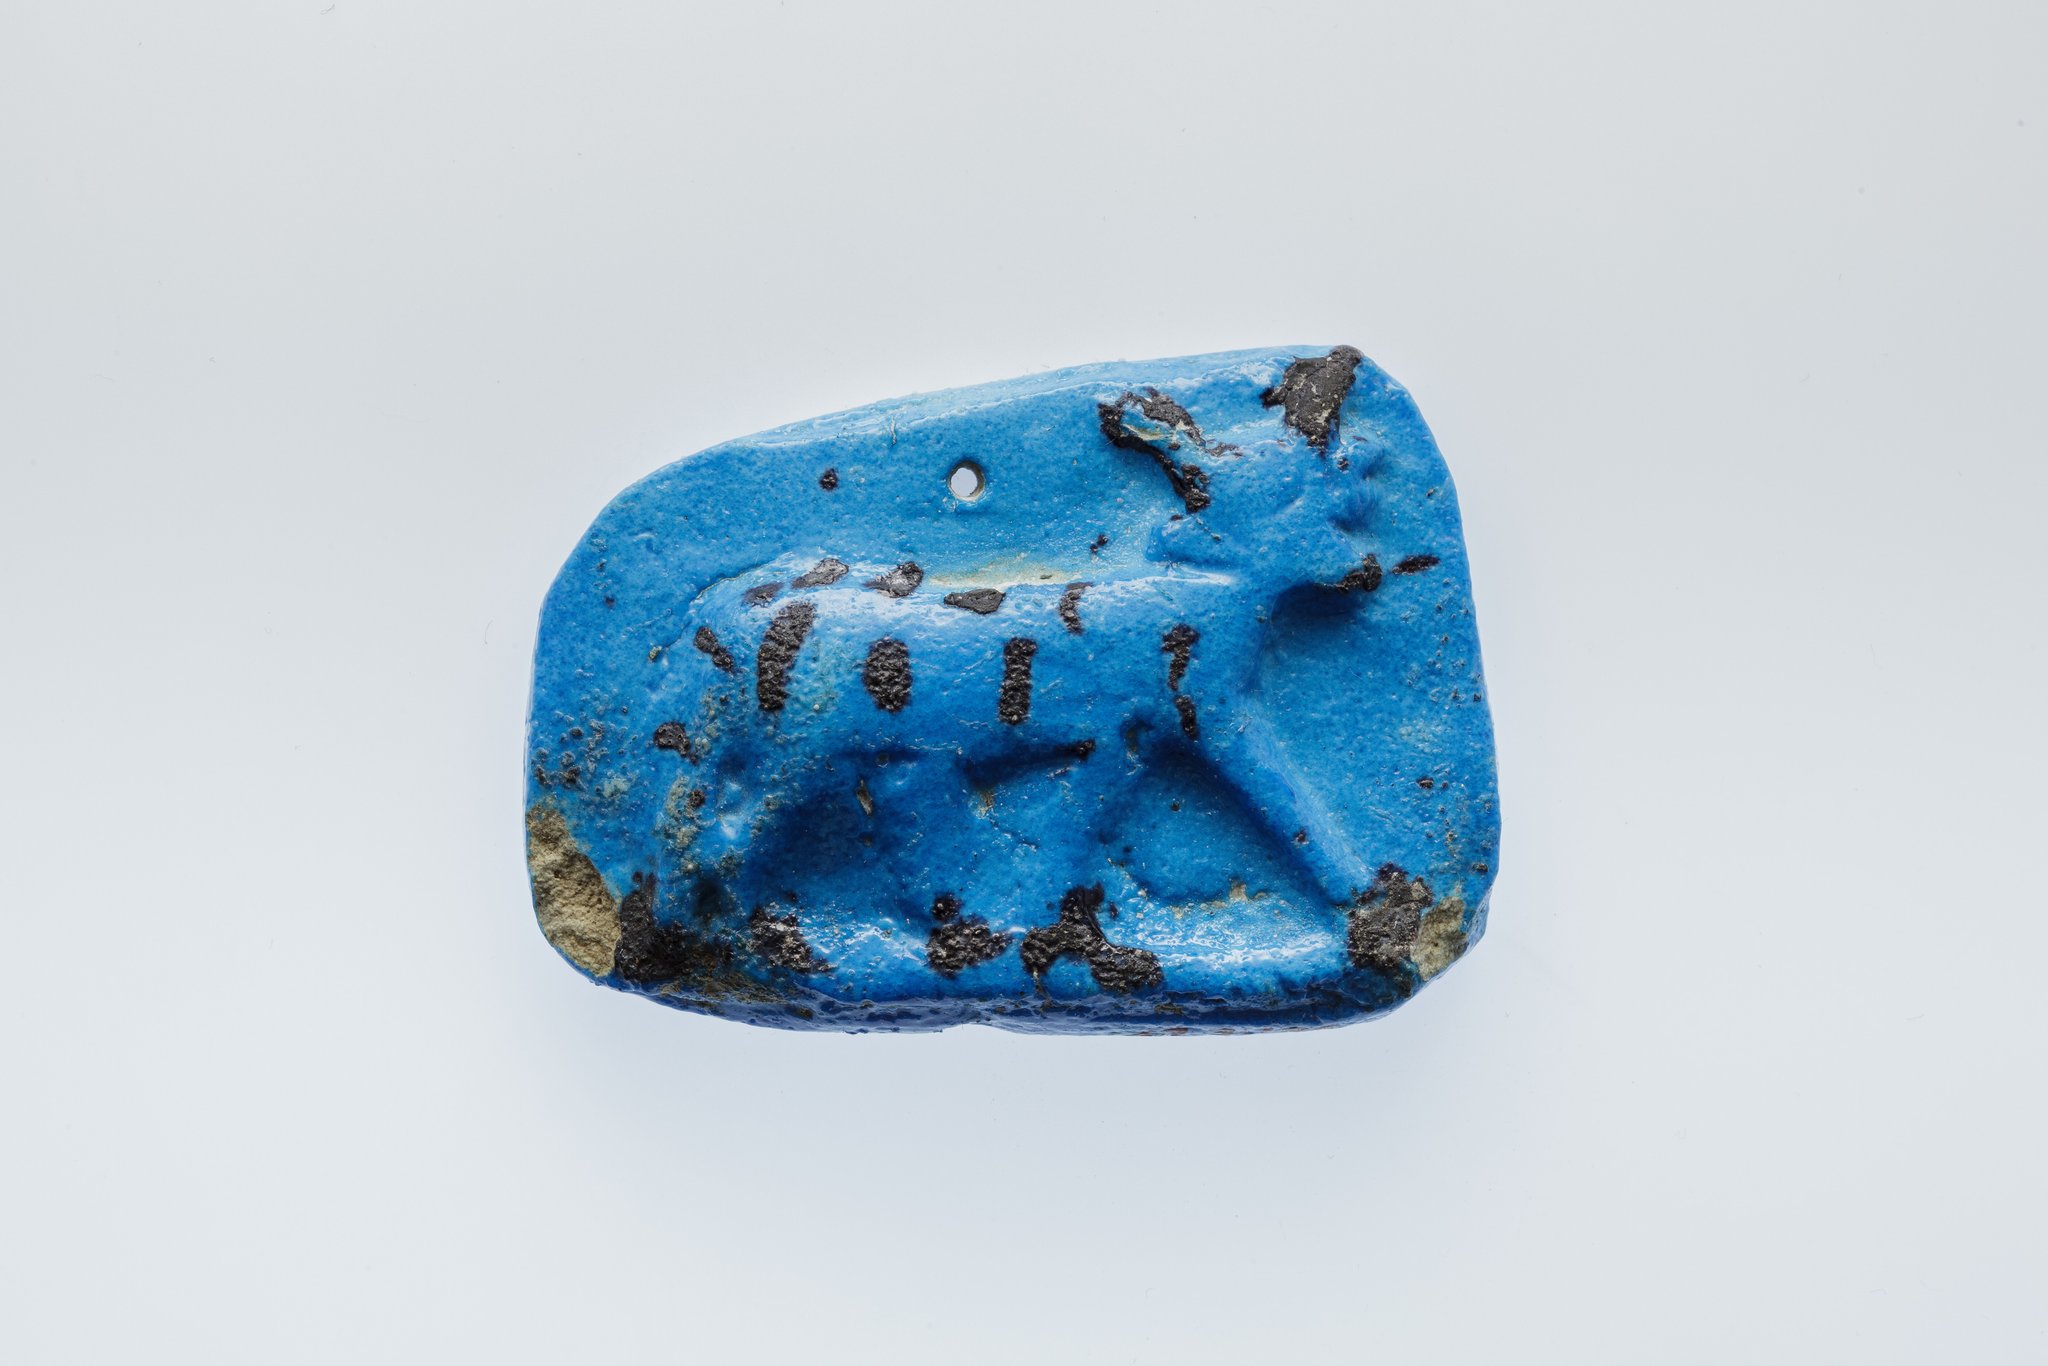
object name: votive, plaque, cow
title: Votive Cow Plaque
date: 1479-1458 BCE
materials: faience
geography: egypt